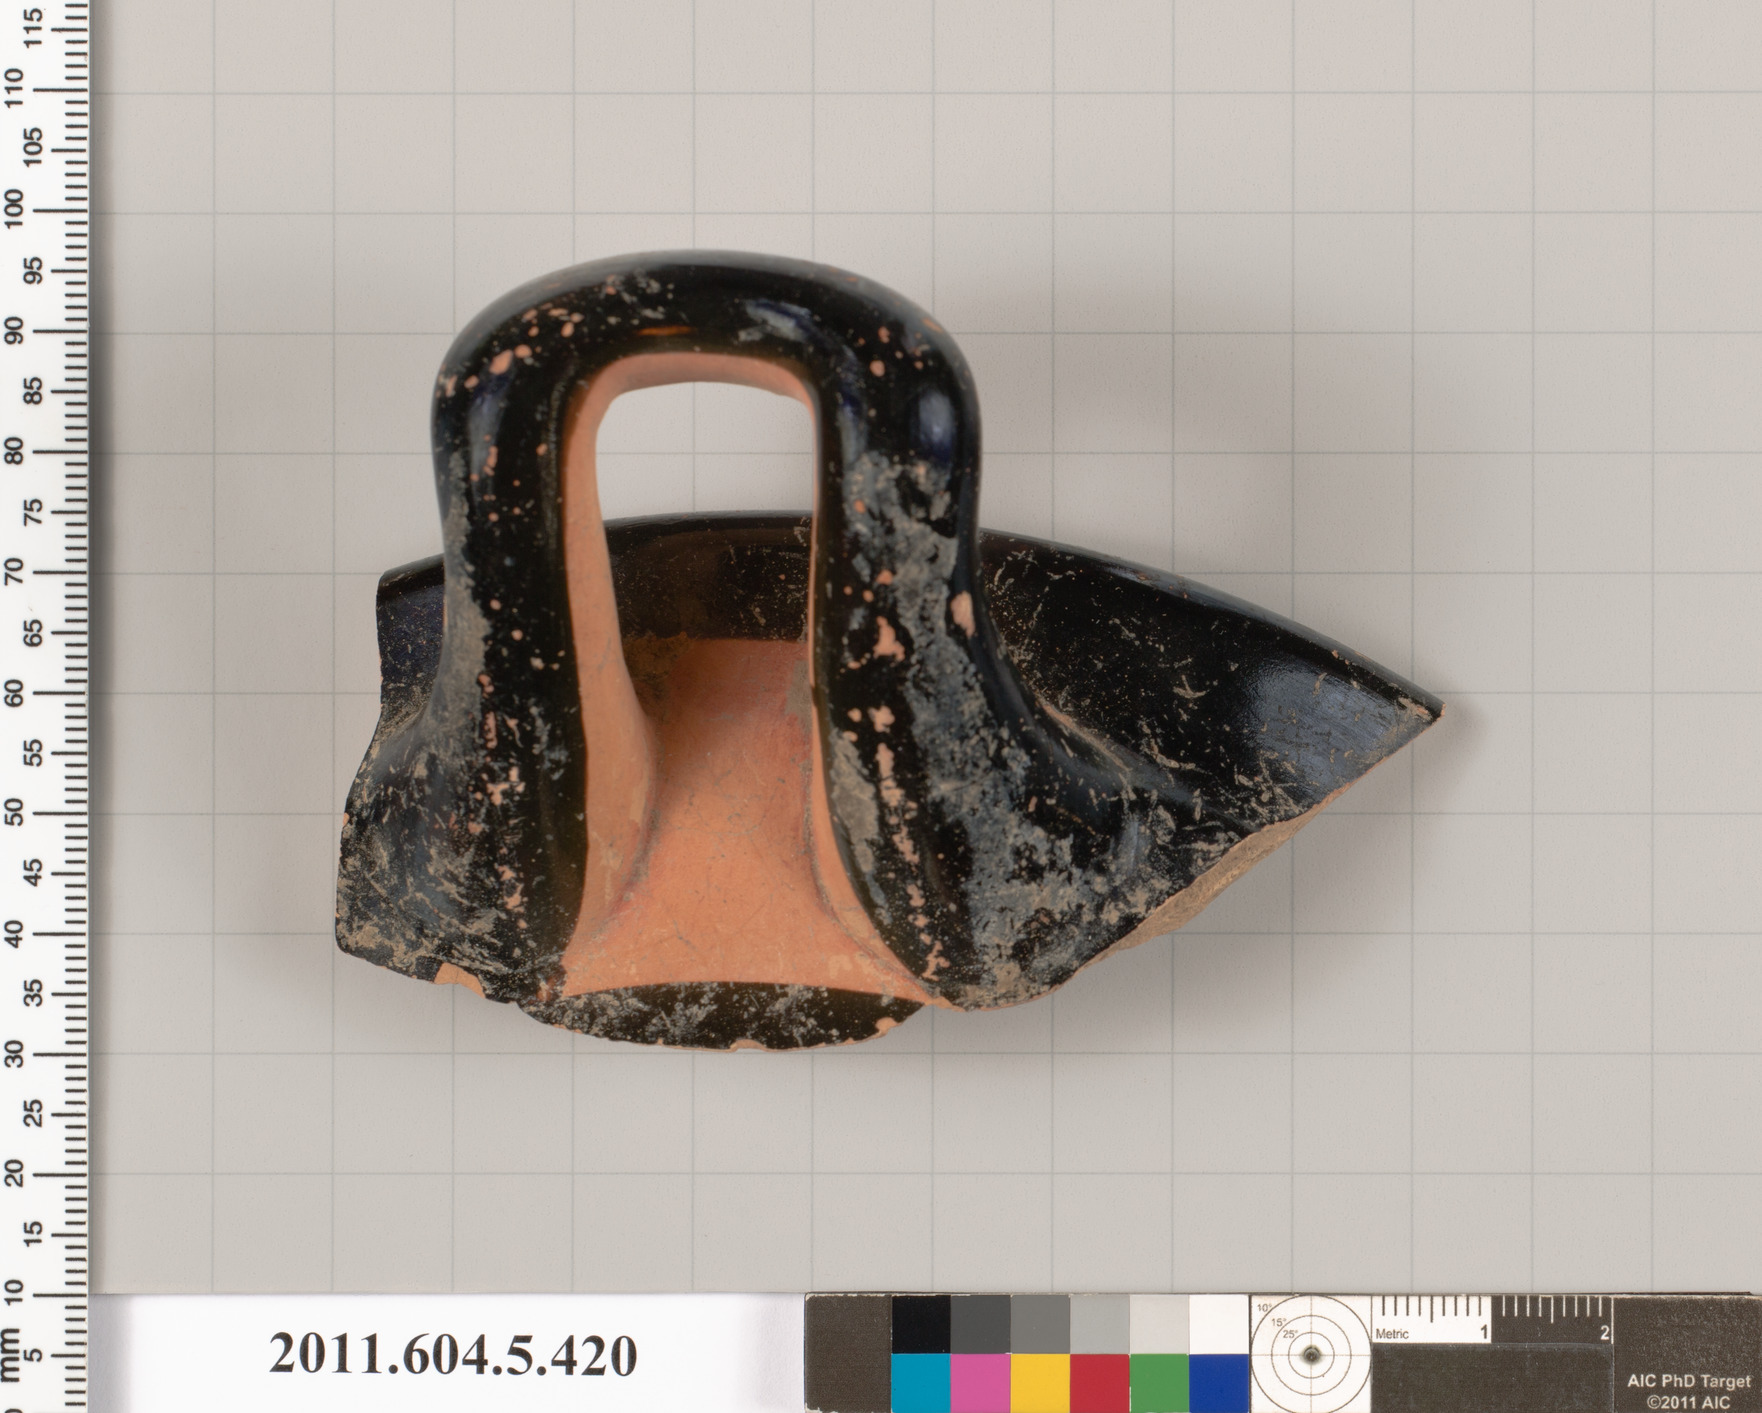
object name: kylix fragment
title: Terracotta rim fragment of a kylix (drinking cup)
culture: greek, attic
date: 500-401 BCE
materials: terracotta